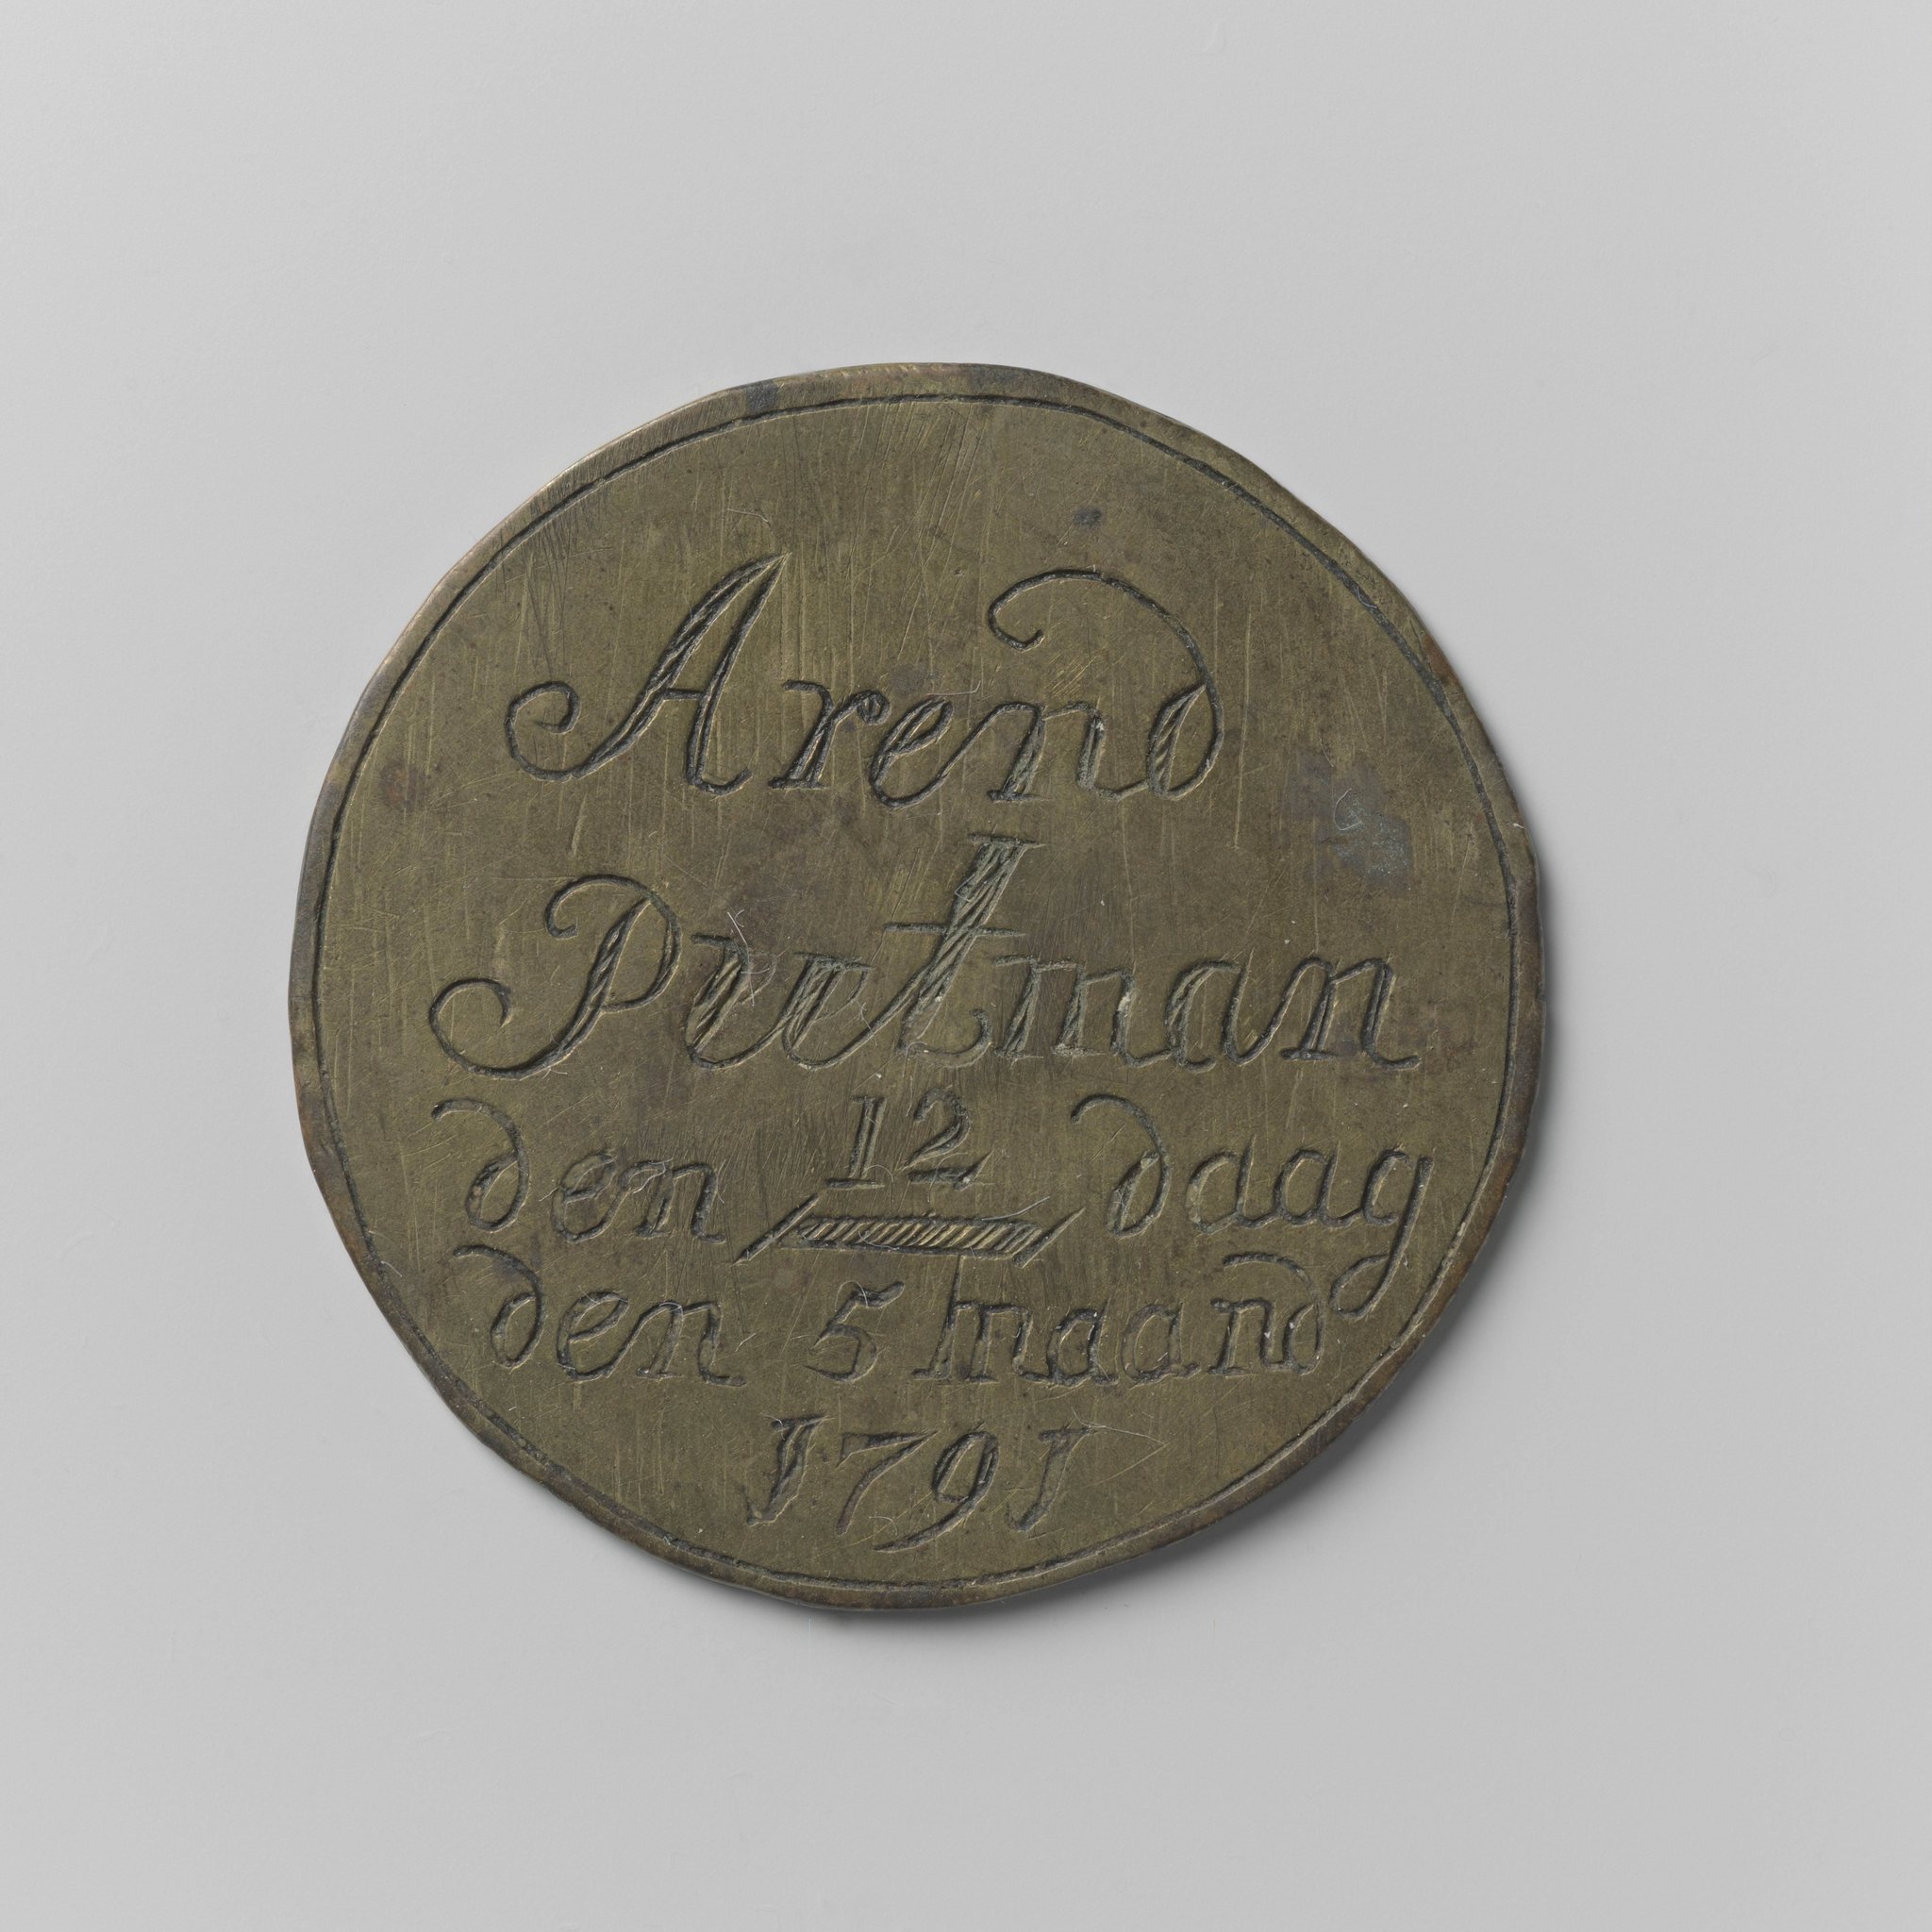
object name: medal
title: Klein binnenlandsvaardersgilde van Amsterdam, gildepenning van Arend Putman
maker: Anonymous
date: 1791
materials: brass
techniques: engraving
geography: amsterdam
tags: amsterdam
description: Messing penning. Voorzijde: naar links varend schip; op achterplecht:vlag met wapenschild. Keerzijde: opschrift